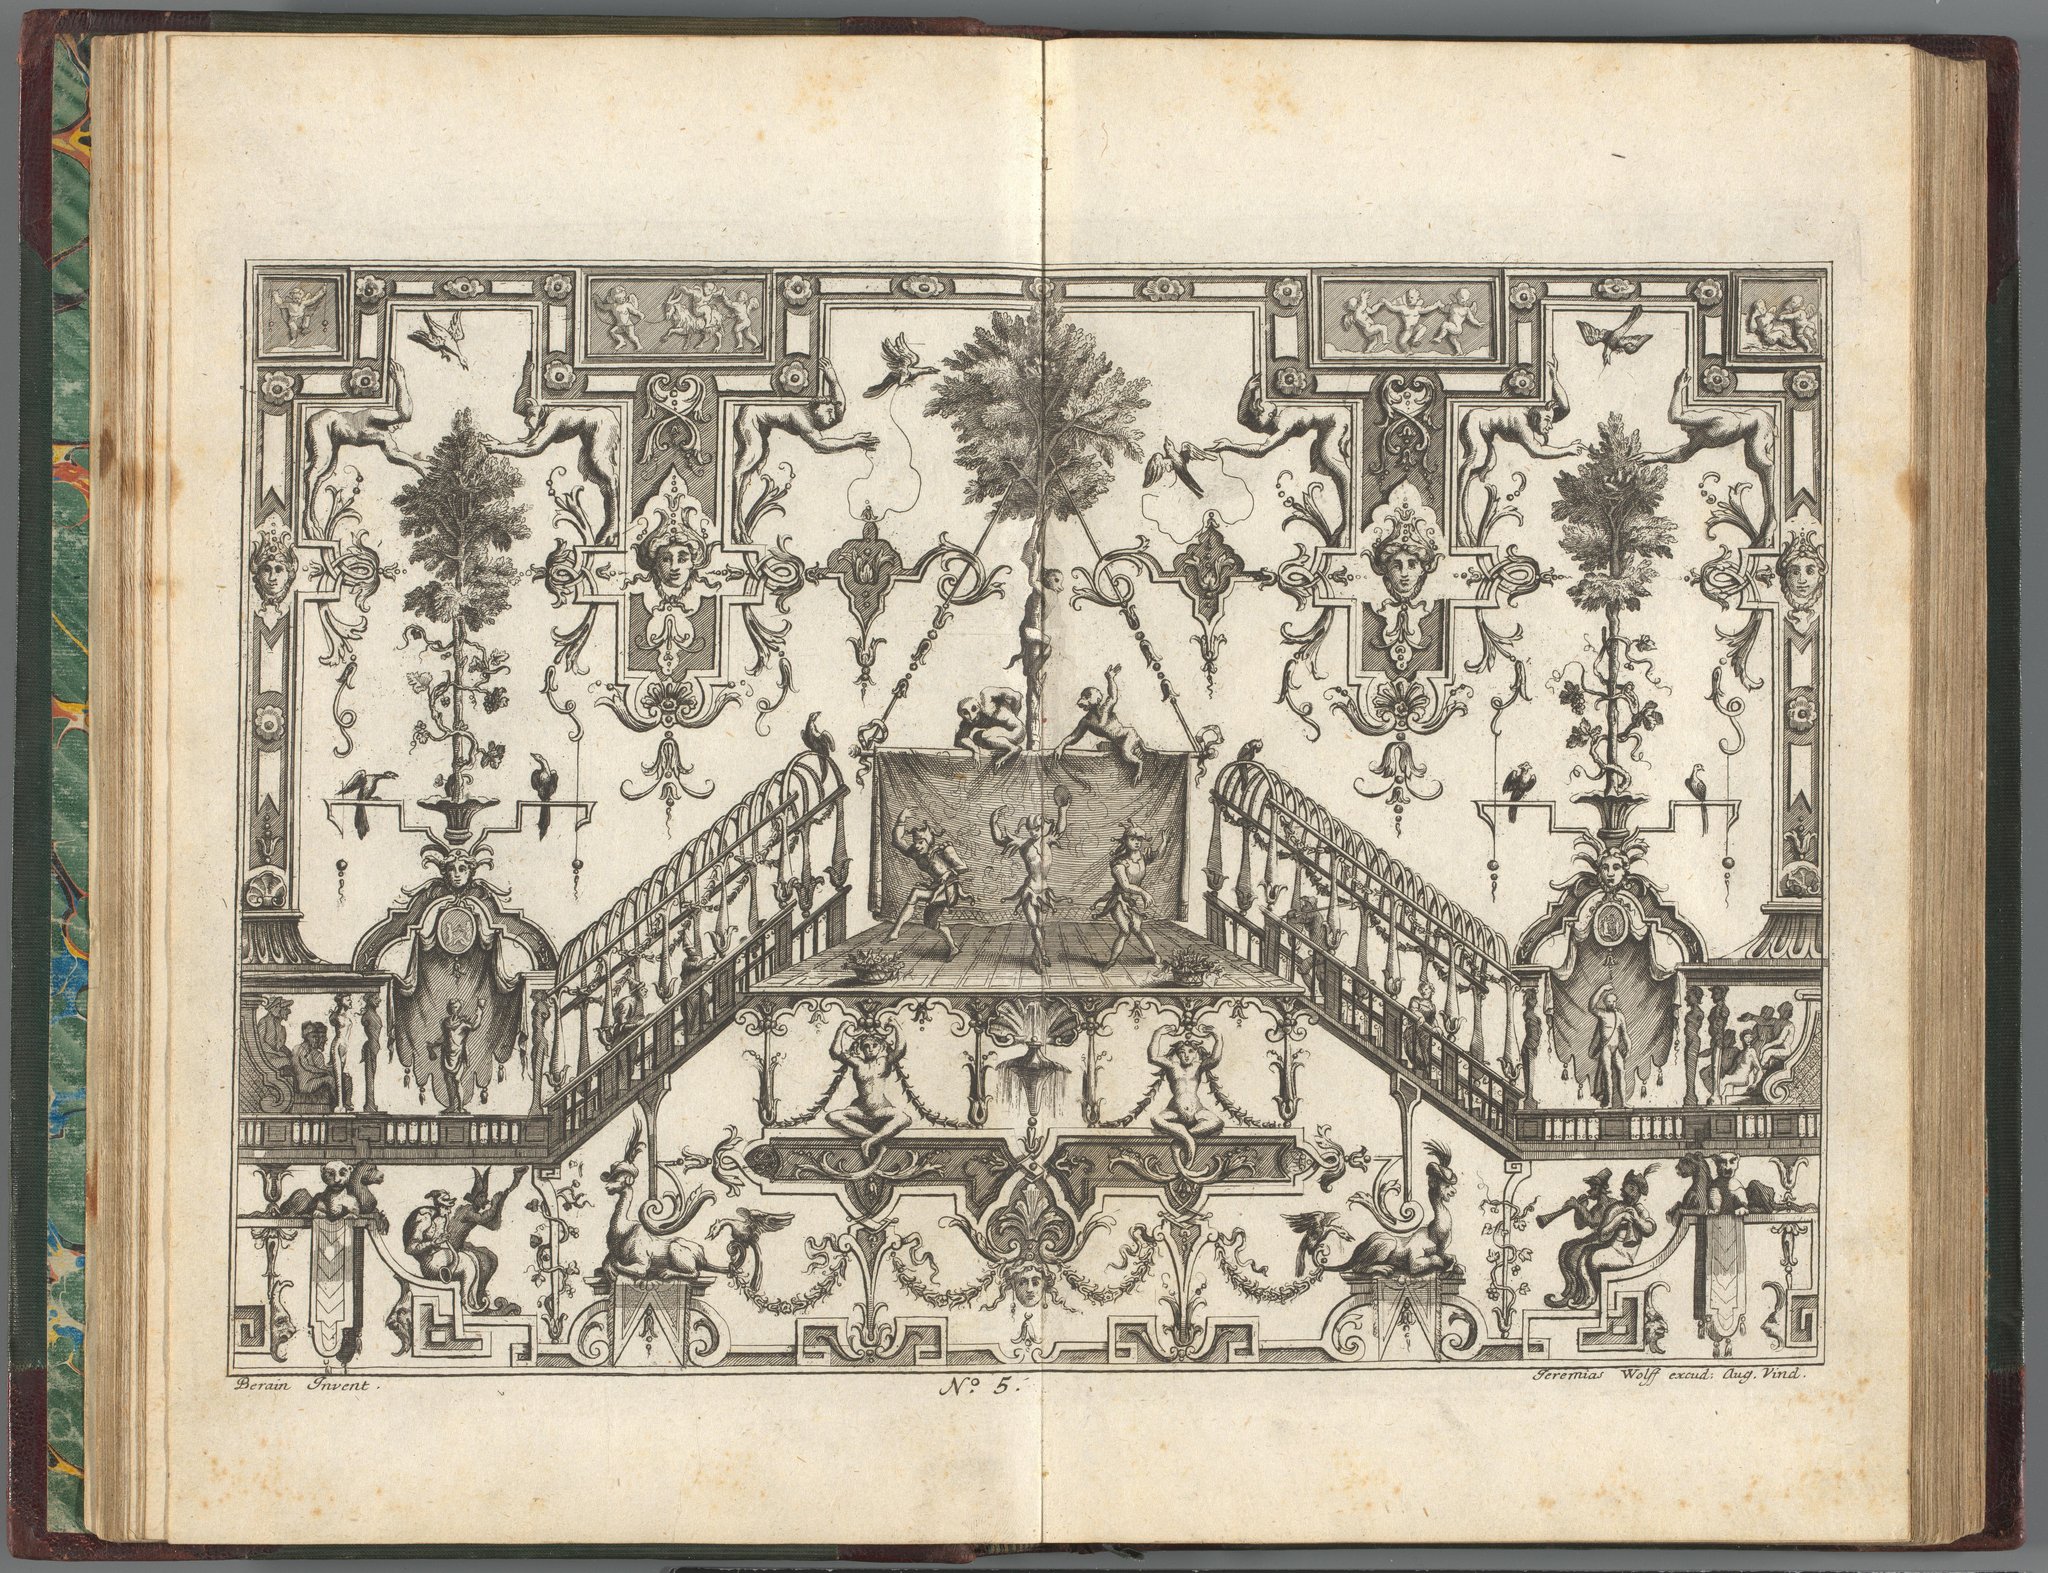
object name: print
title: Compositie met dansende narren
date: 1686-1724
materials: paper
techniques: etching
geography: augsburg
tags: court jester, court fool, ornaments ~ art, group dancing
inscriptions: signature: ‘Berain Invent.’, number: ‘No. 5’, signature: ‘Ieremias Wolff excud. Aug. Vind.’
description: Een decoratieve compositie met vlechtwerk en drie bomen. Onder de middelste boom dansen drie narren op een podium. Links en rechts leidt een trap naar beneden naar een balustrade met een beeld van Bacchus en Apollo. Onder de balustrades zitten muzikanten. Midden onder diverse fantasiedieren en -figuren. Prent maakt deel uit van een album. Hoogstwaarschijnlijk gespiegelde kopie naar Frans origineel.